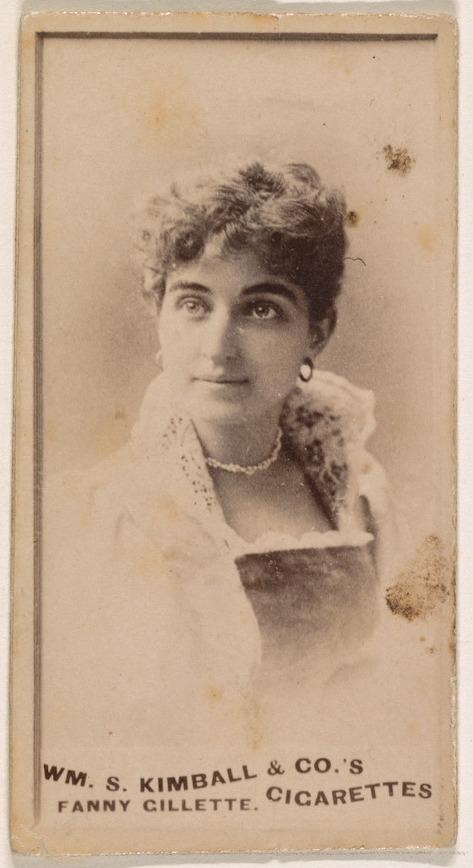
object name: photograph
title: Fanny Gillette, from the Actresses series (N203) issued by Wm. S. Kimball & Co.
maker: william s. kimball & company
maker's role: publisher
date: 1889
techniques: color lithograph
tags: portraits,women,actresses